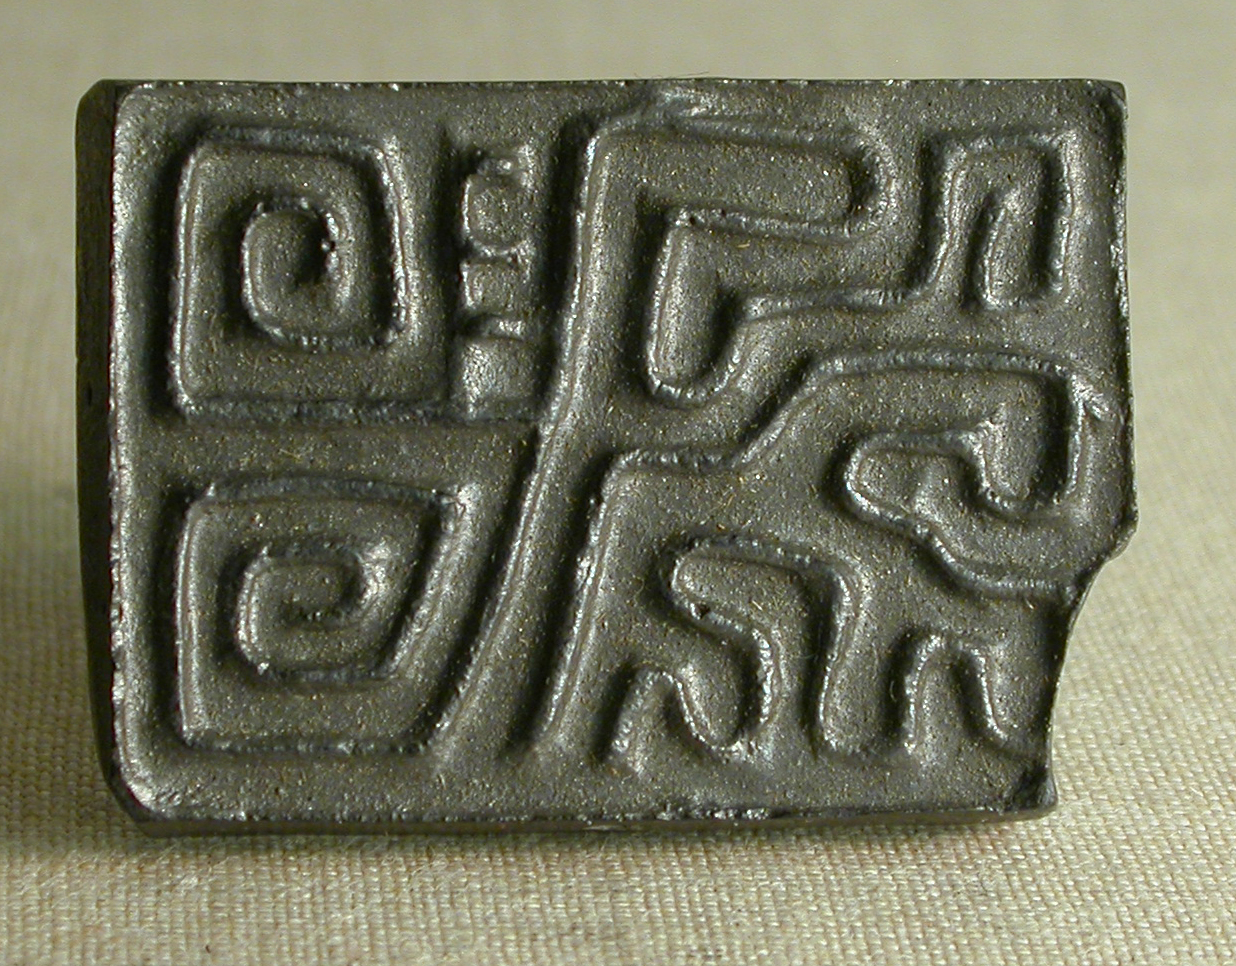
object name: seal, stamp, labyrinth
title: Pyramid-Shaped Stamp Seal Inscribed With A Labyrinth Design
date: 2150-2040 BCE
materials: limestone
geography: egypt